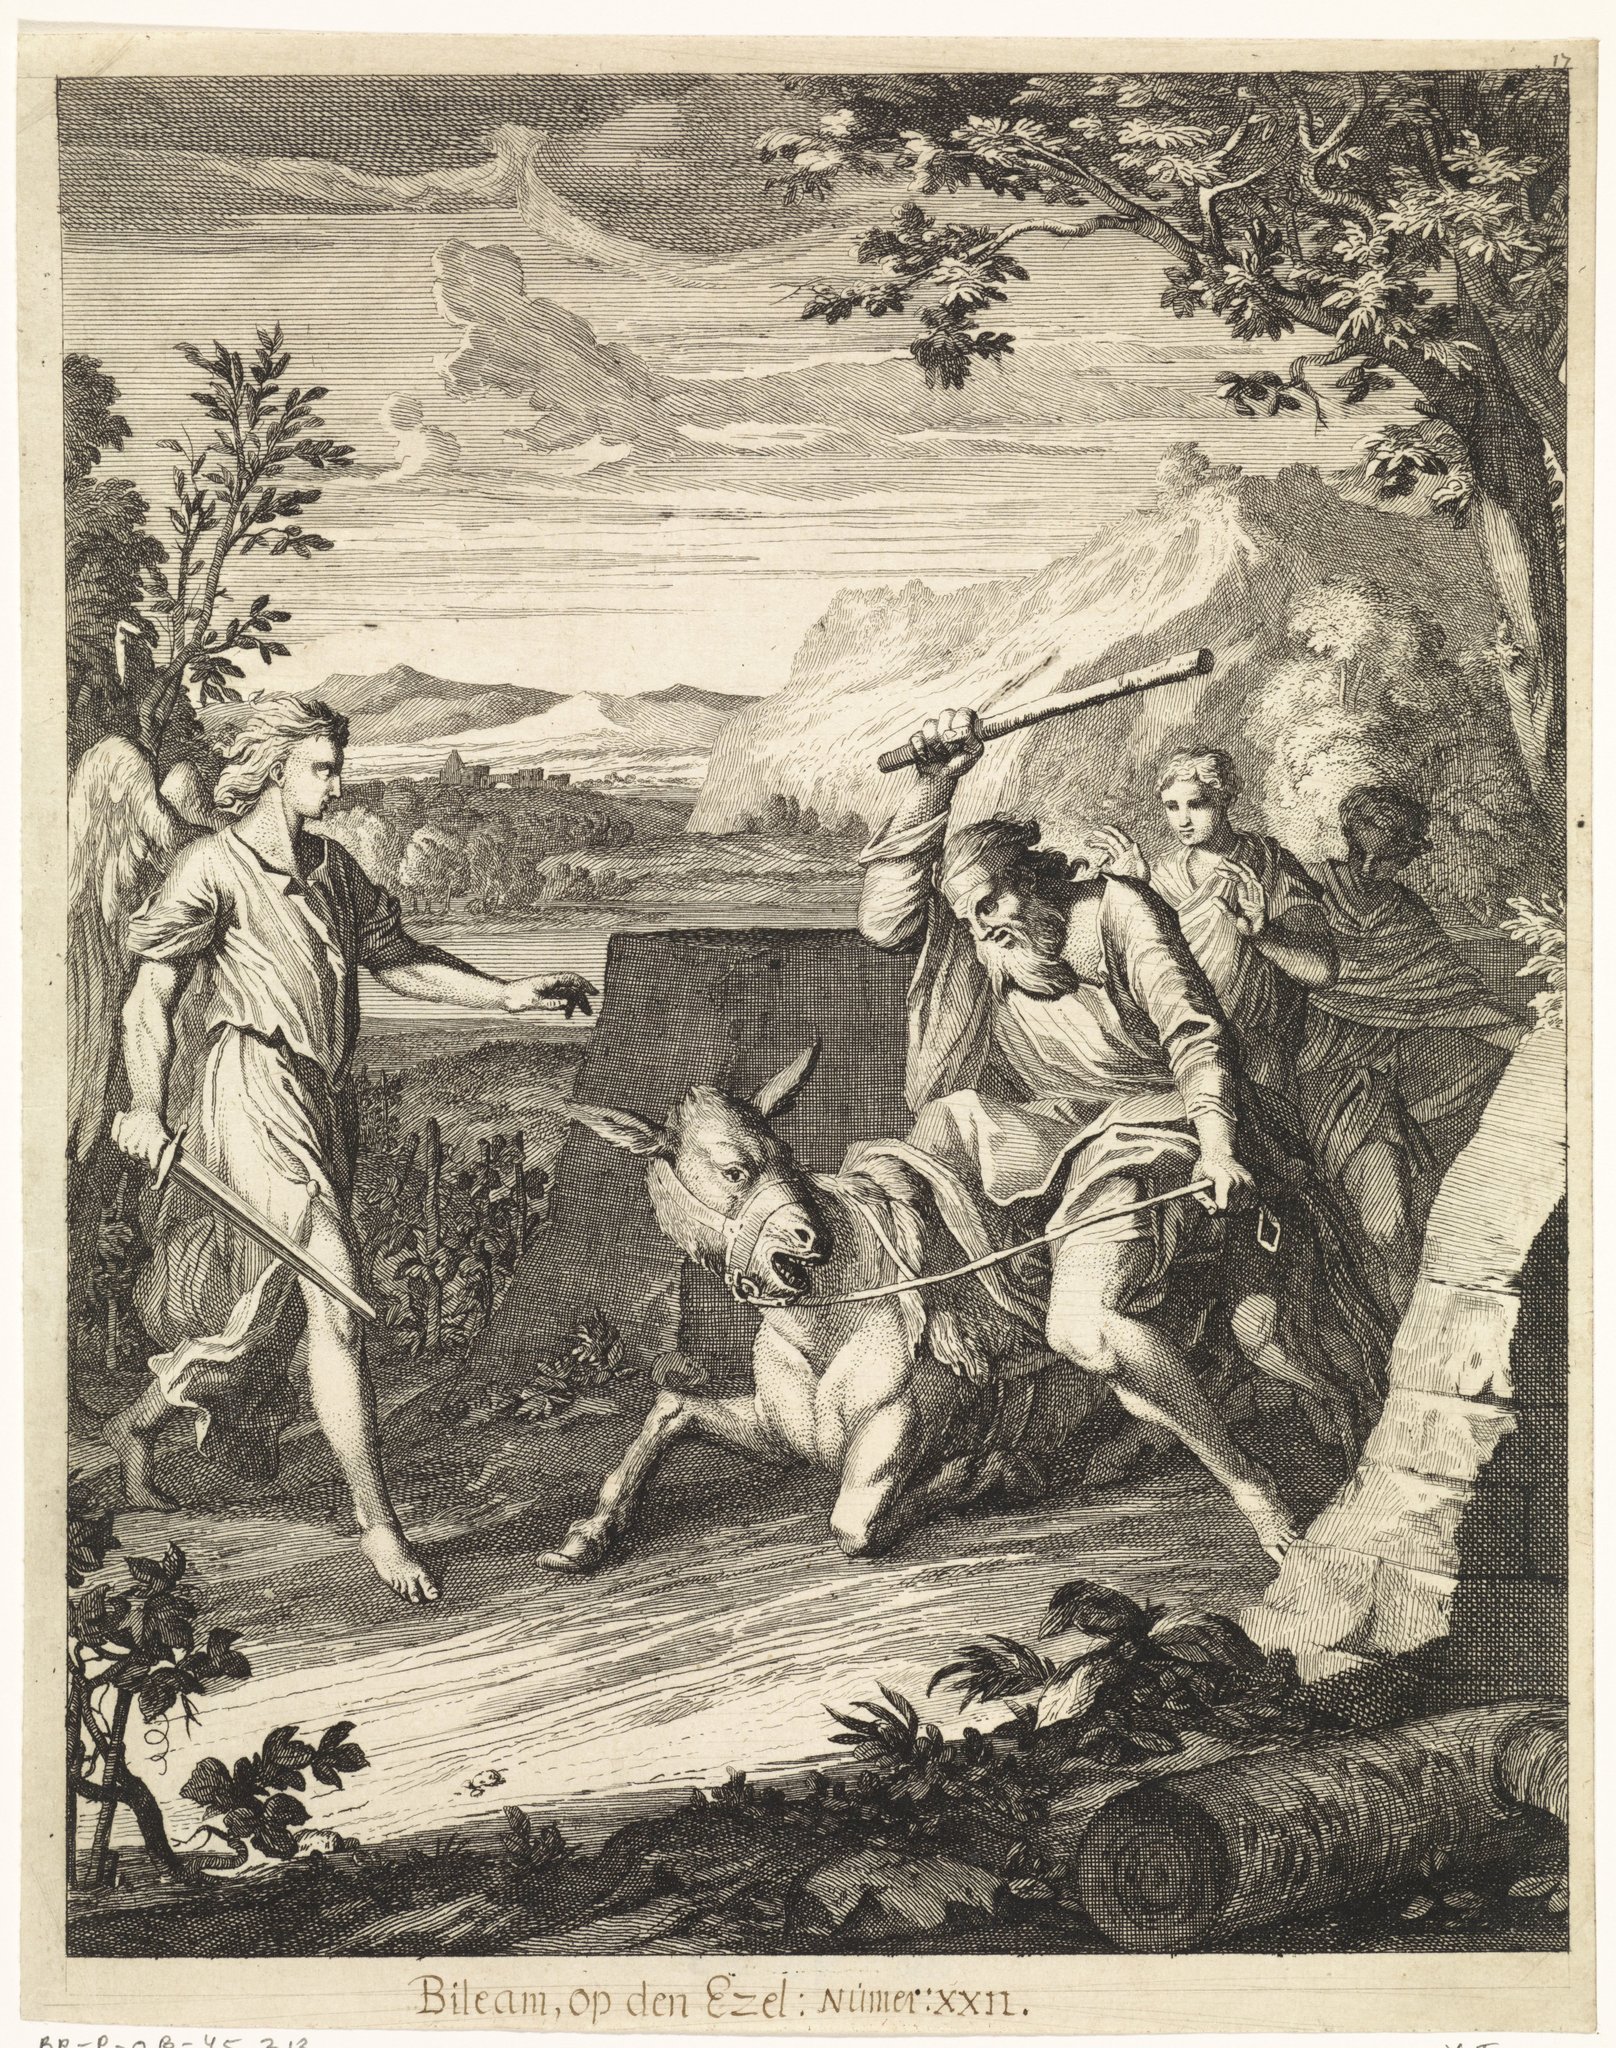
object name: print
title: Bileam en zijn ezel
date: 1708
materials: paper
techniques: etching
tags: an angel holding a sword bars the way and causes balaam's ass to turn aside; the angel is invisible to balaam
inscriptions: collector's mark: Lugt 2228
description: Proefdruk van een prent welke is opgenomen als illustratie in: Historiae Celebriores Veteris Testamenti. Christoph Weigel, 1708.